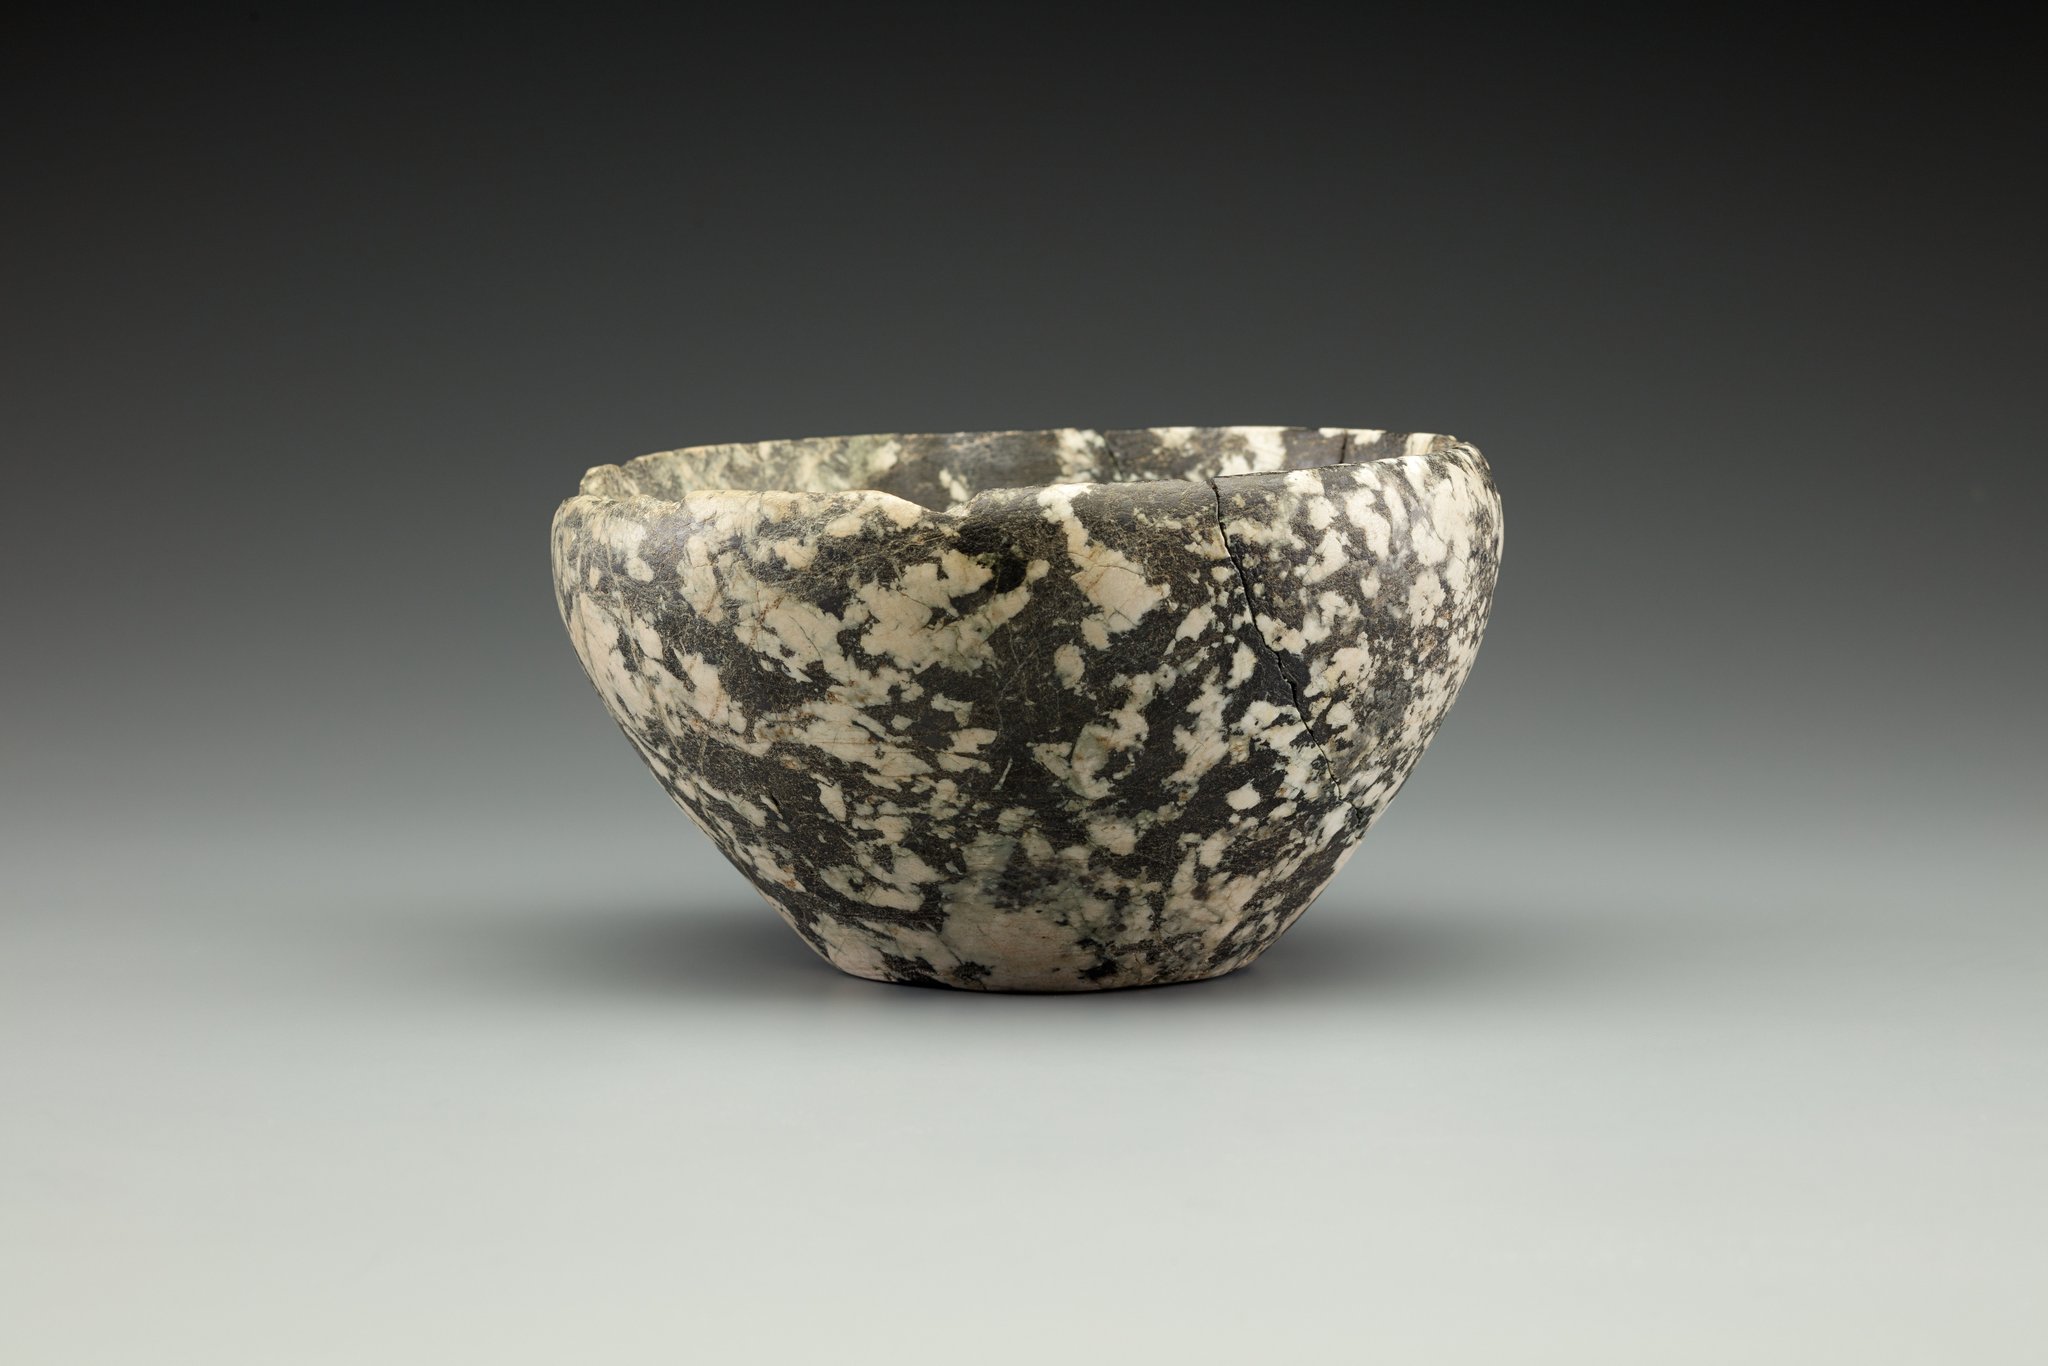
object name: bowl, deep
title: Deep bowl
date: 3850-2960 BCE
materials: stone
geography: egypt